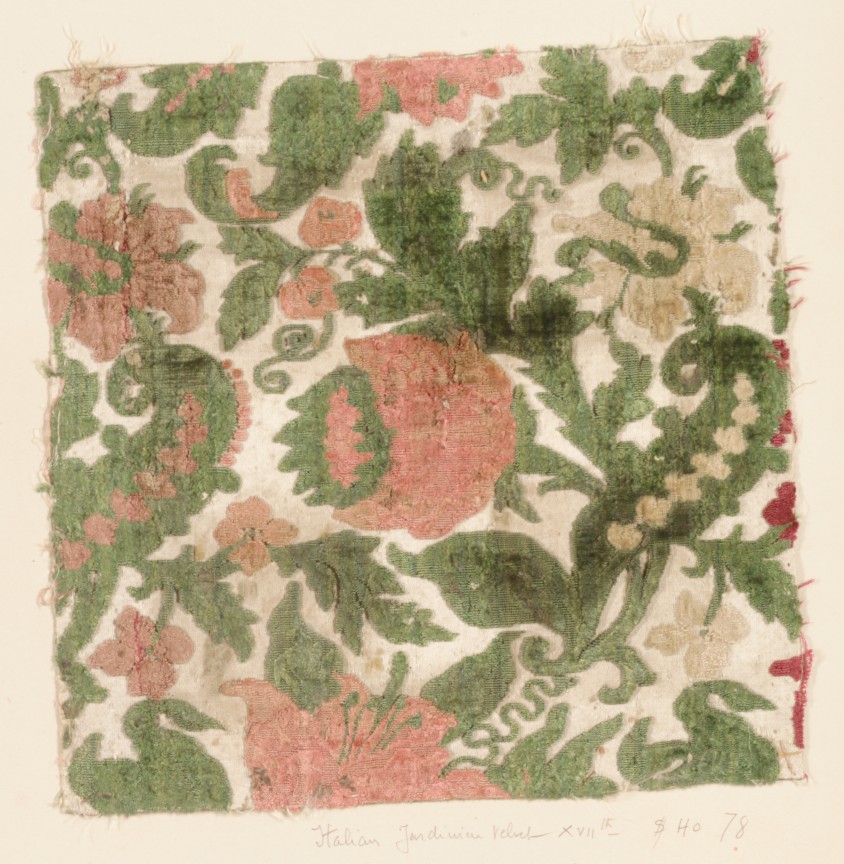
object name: fragment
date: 1601-1700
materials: silk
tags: flowers,leaves